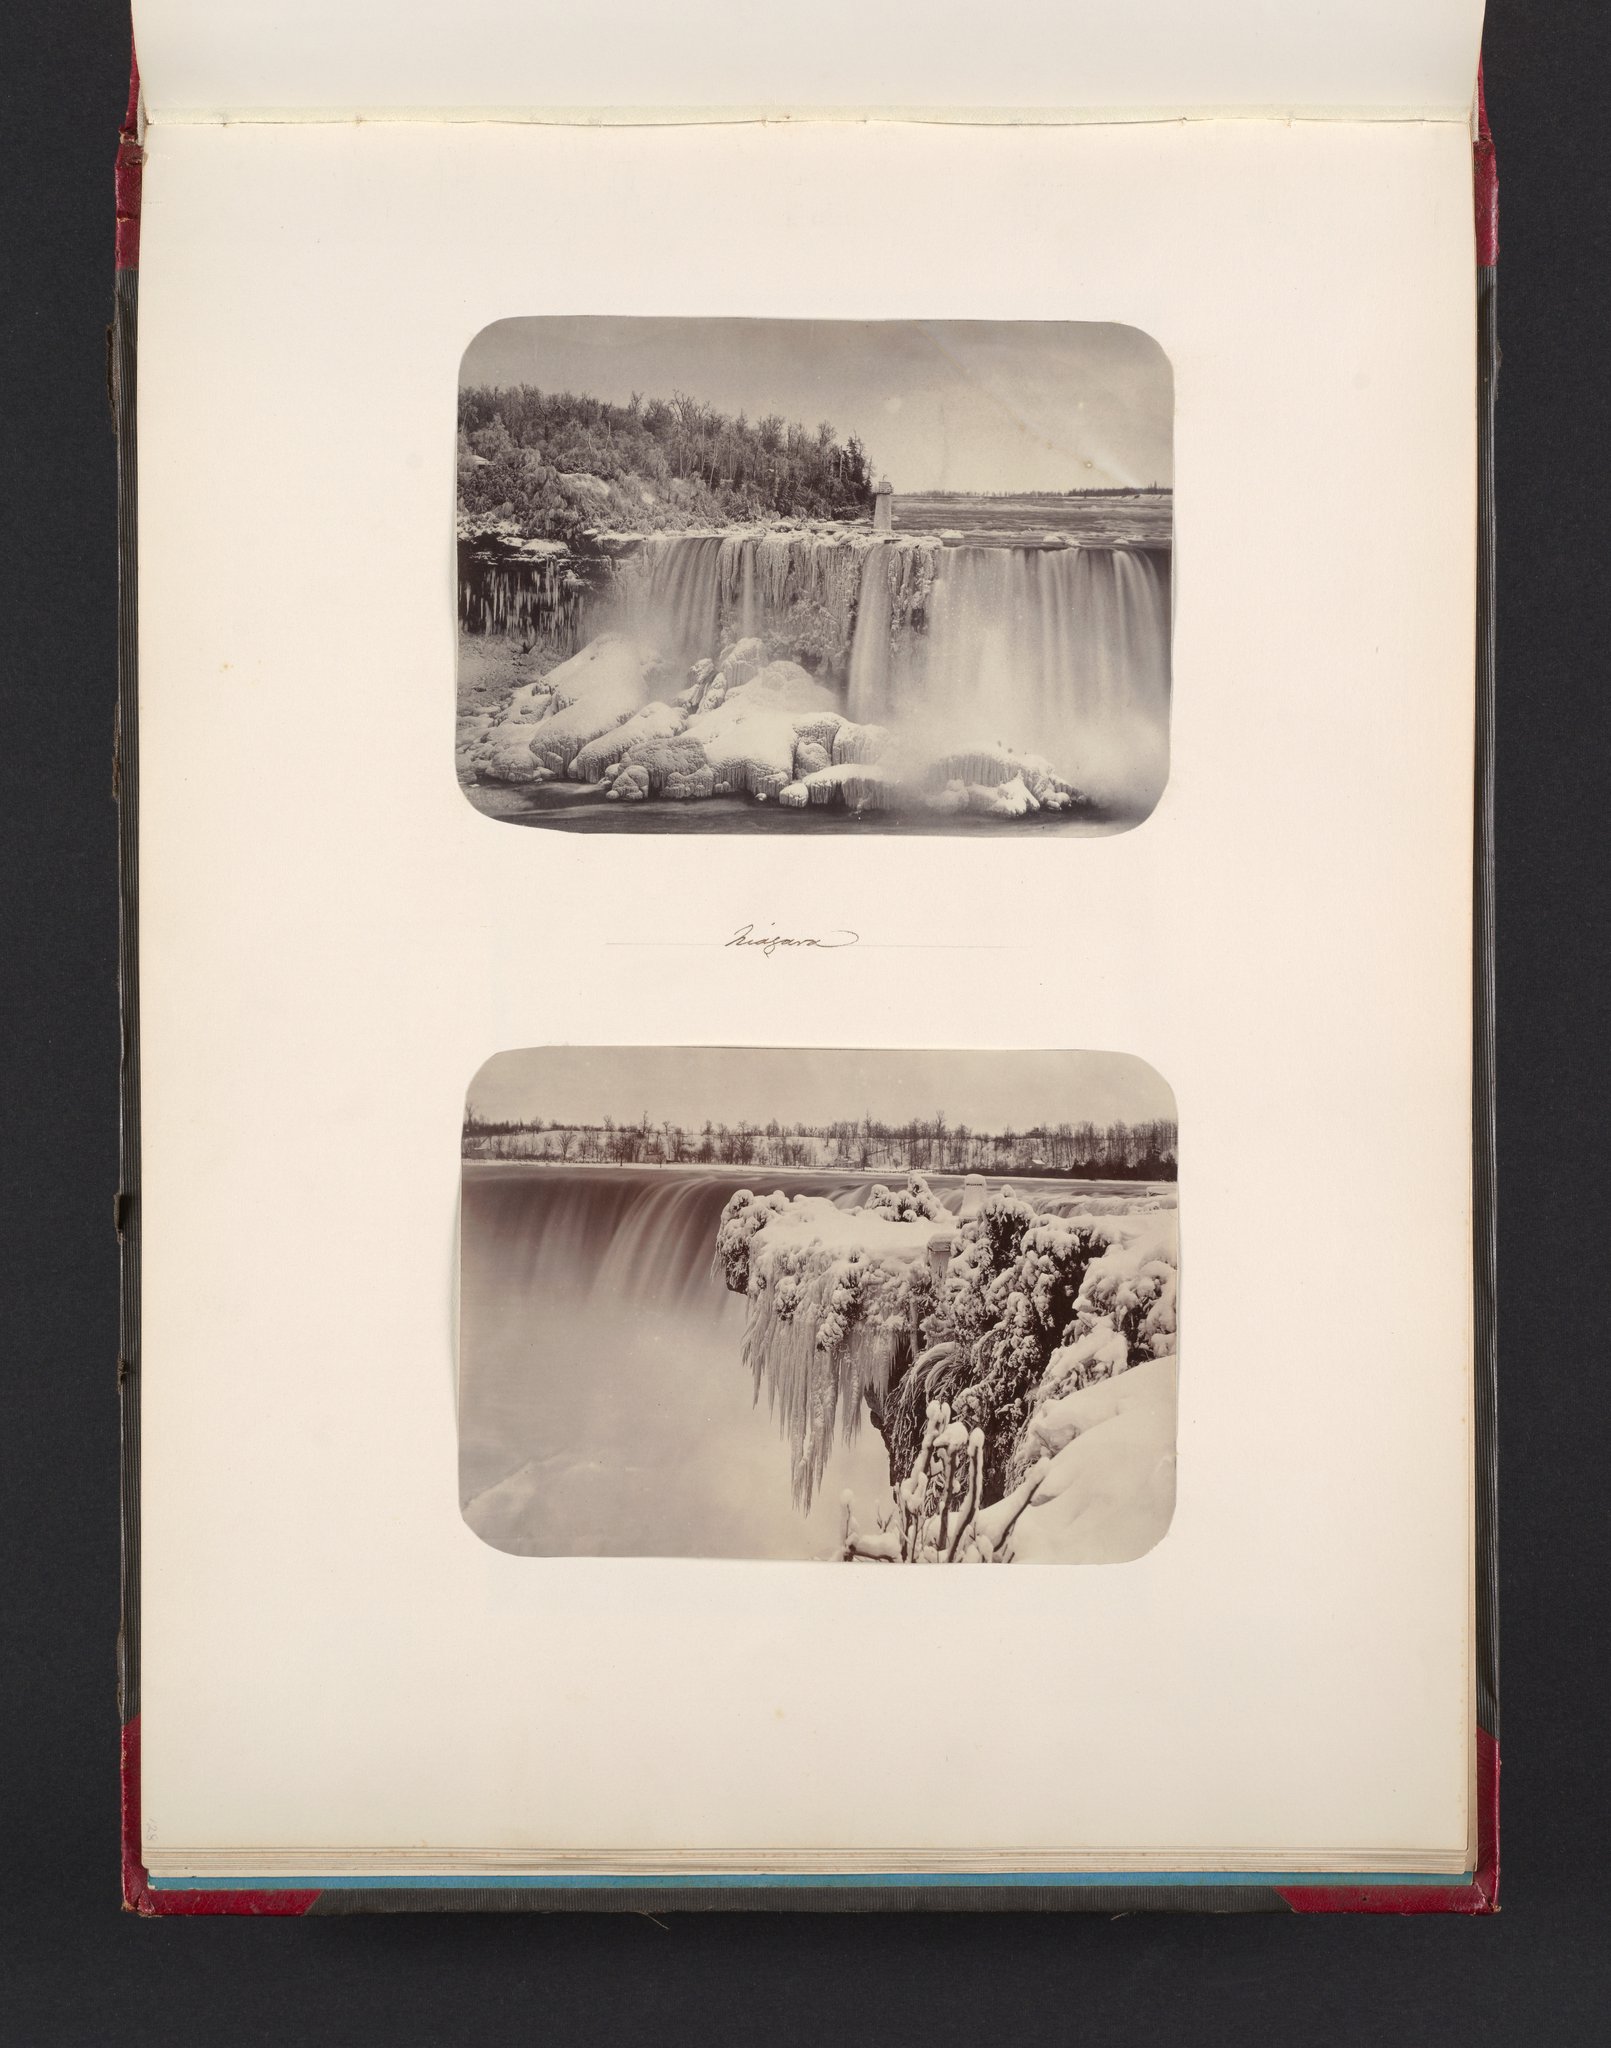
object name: photograph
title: Niagara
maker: john thomson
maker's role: artist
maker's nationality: british, scottish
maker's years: 1837-1921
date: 1865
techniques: albumen silver print, glass negative